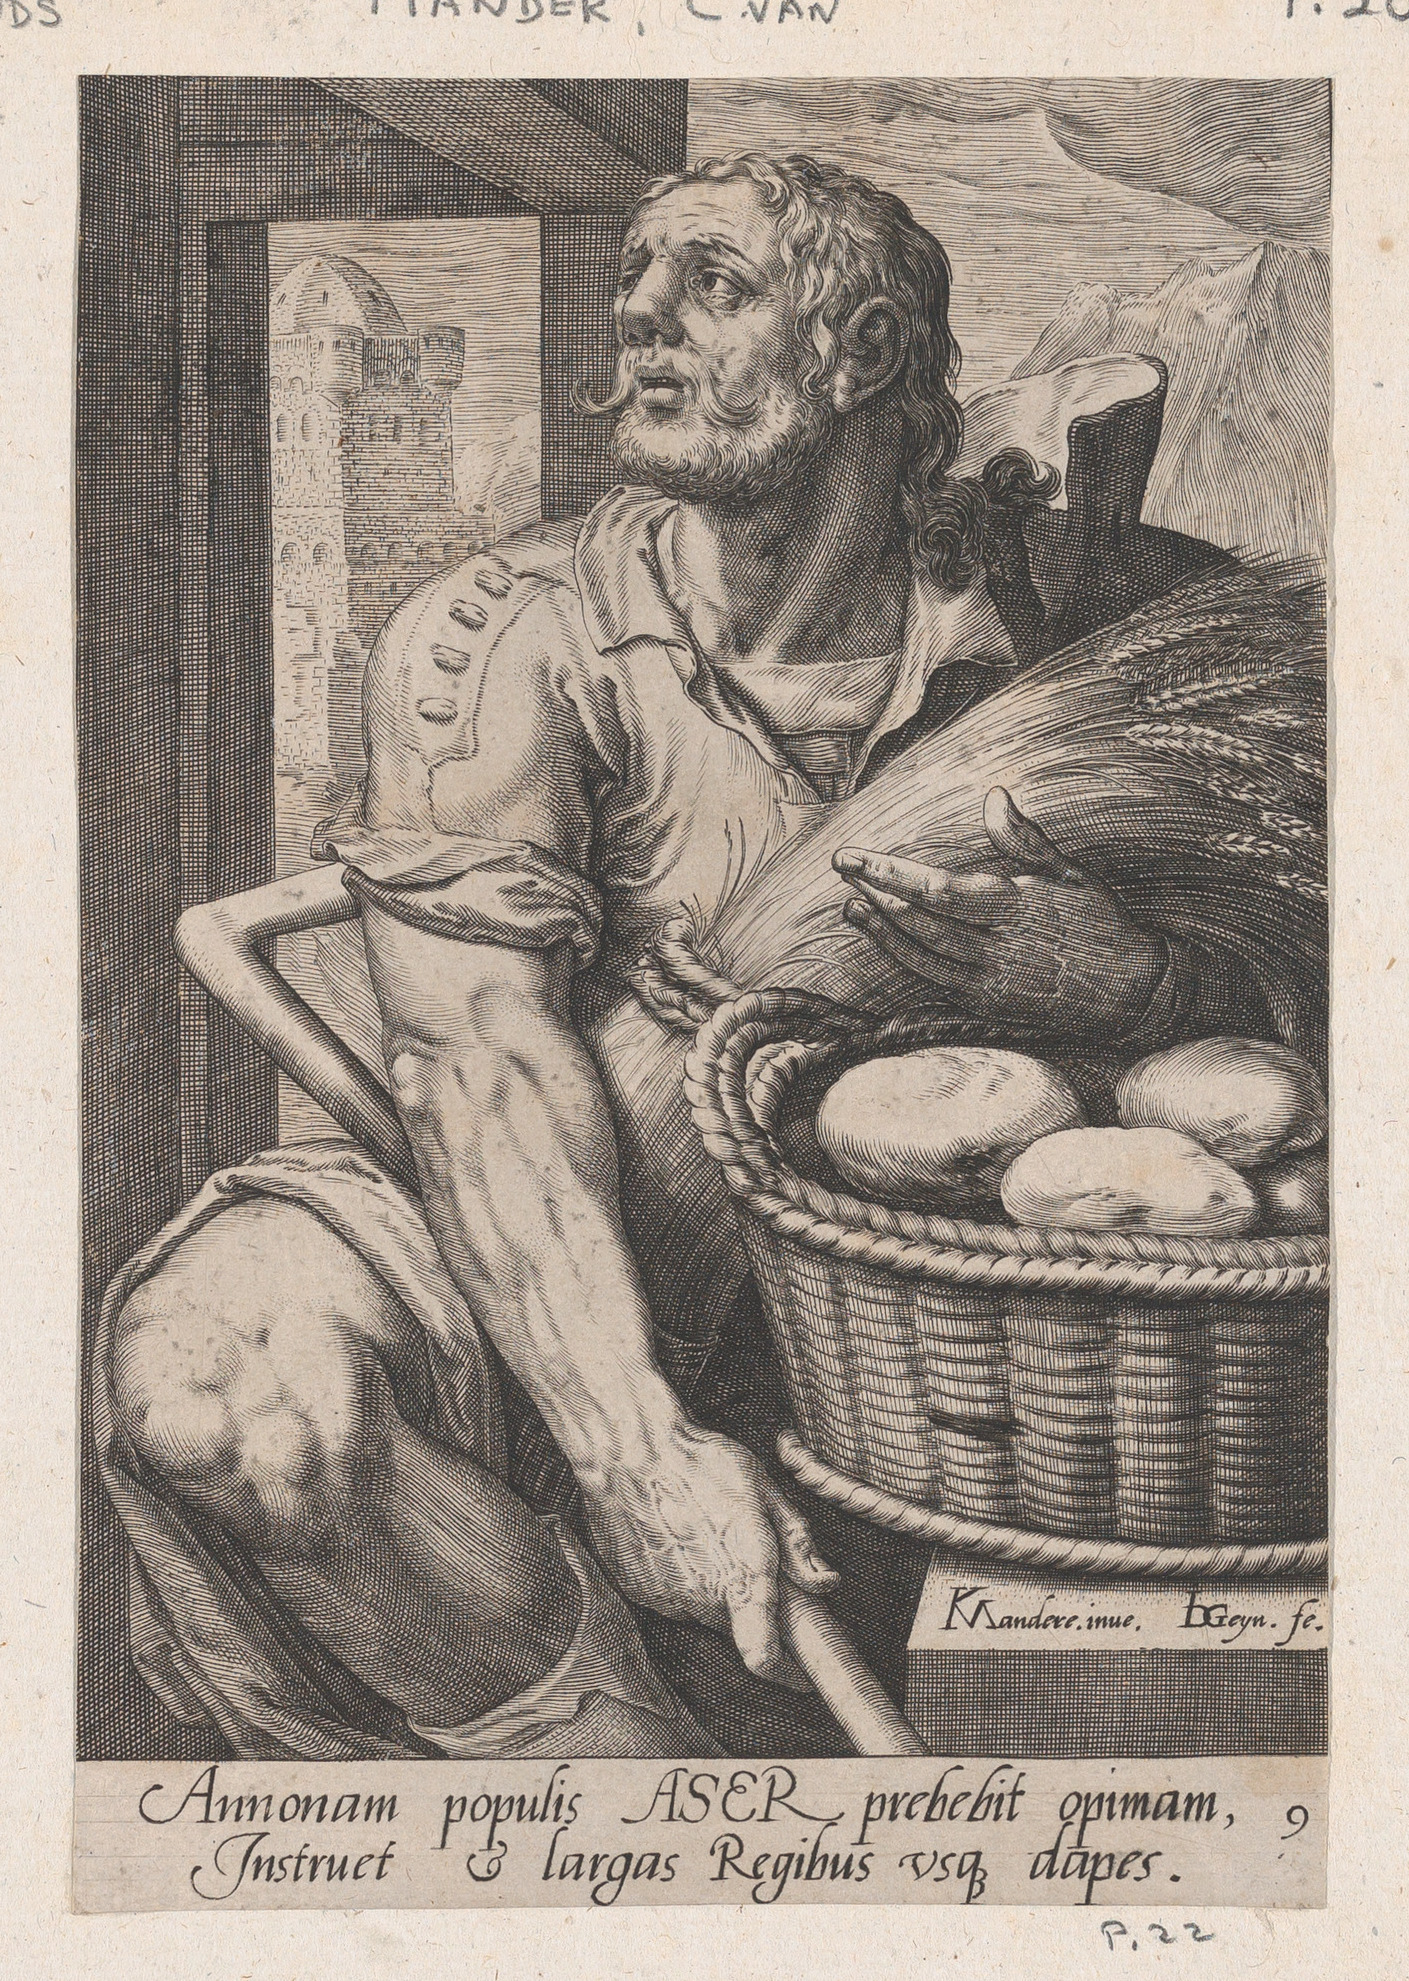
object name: print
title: Asher, from "The Twelve Sons of Jacob"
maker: jacques de gheyn (ii)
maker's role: artist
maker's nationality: netherlandish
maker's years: 1565-1629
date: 1584-1594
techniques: engraving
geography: amsterdam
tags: food,men,portraits